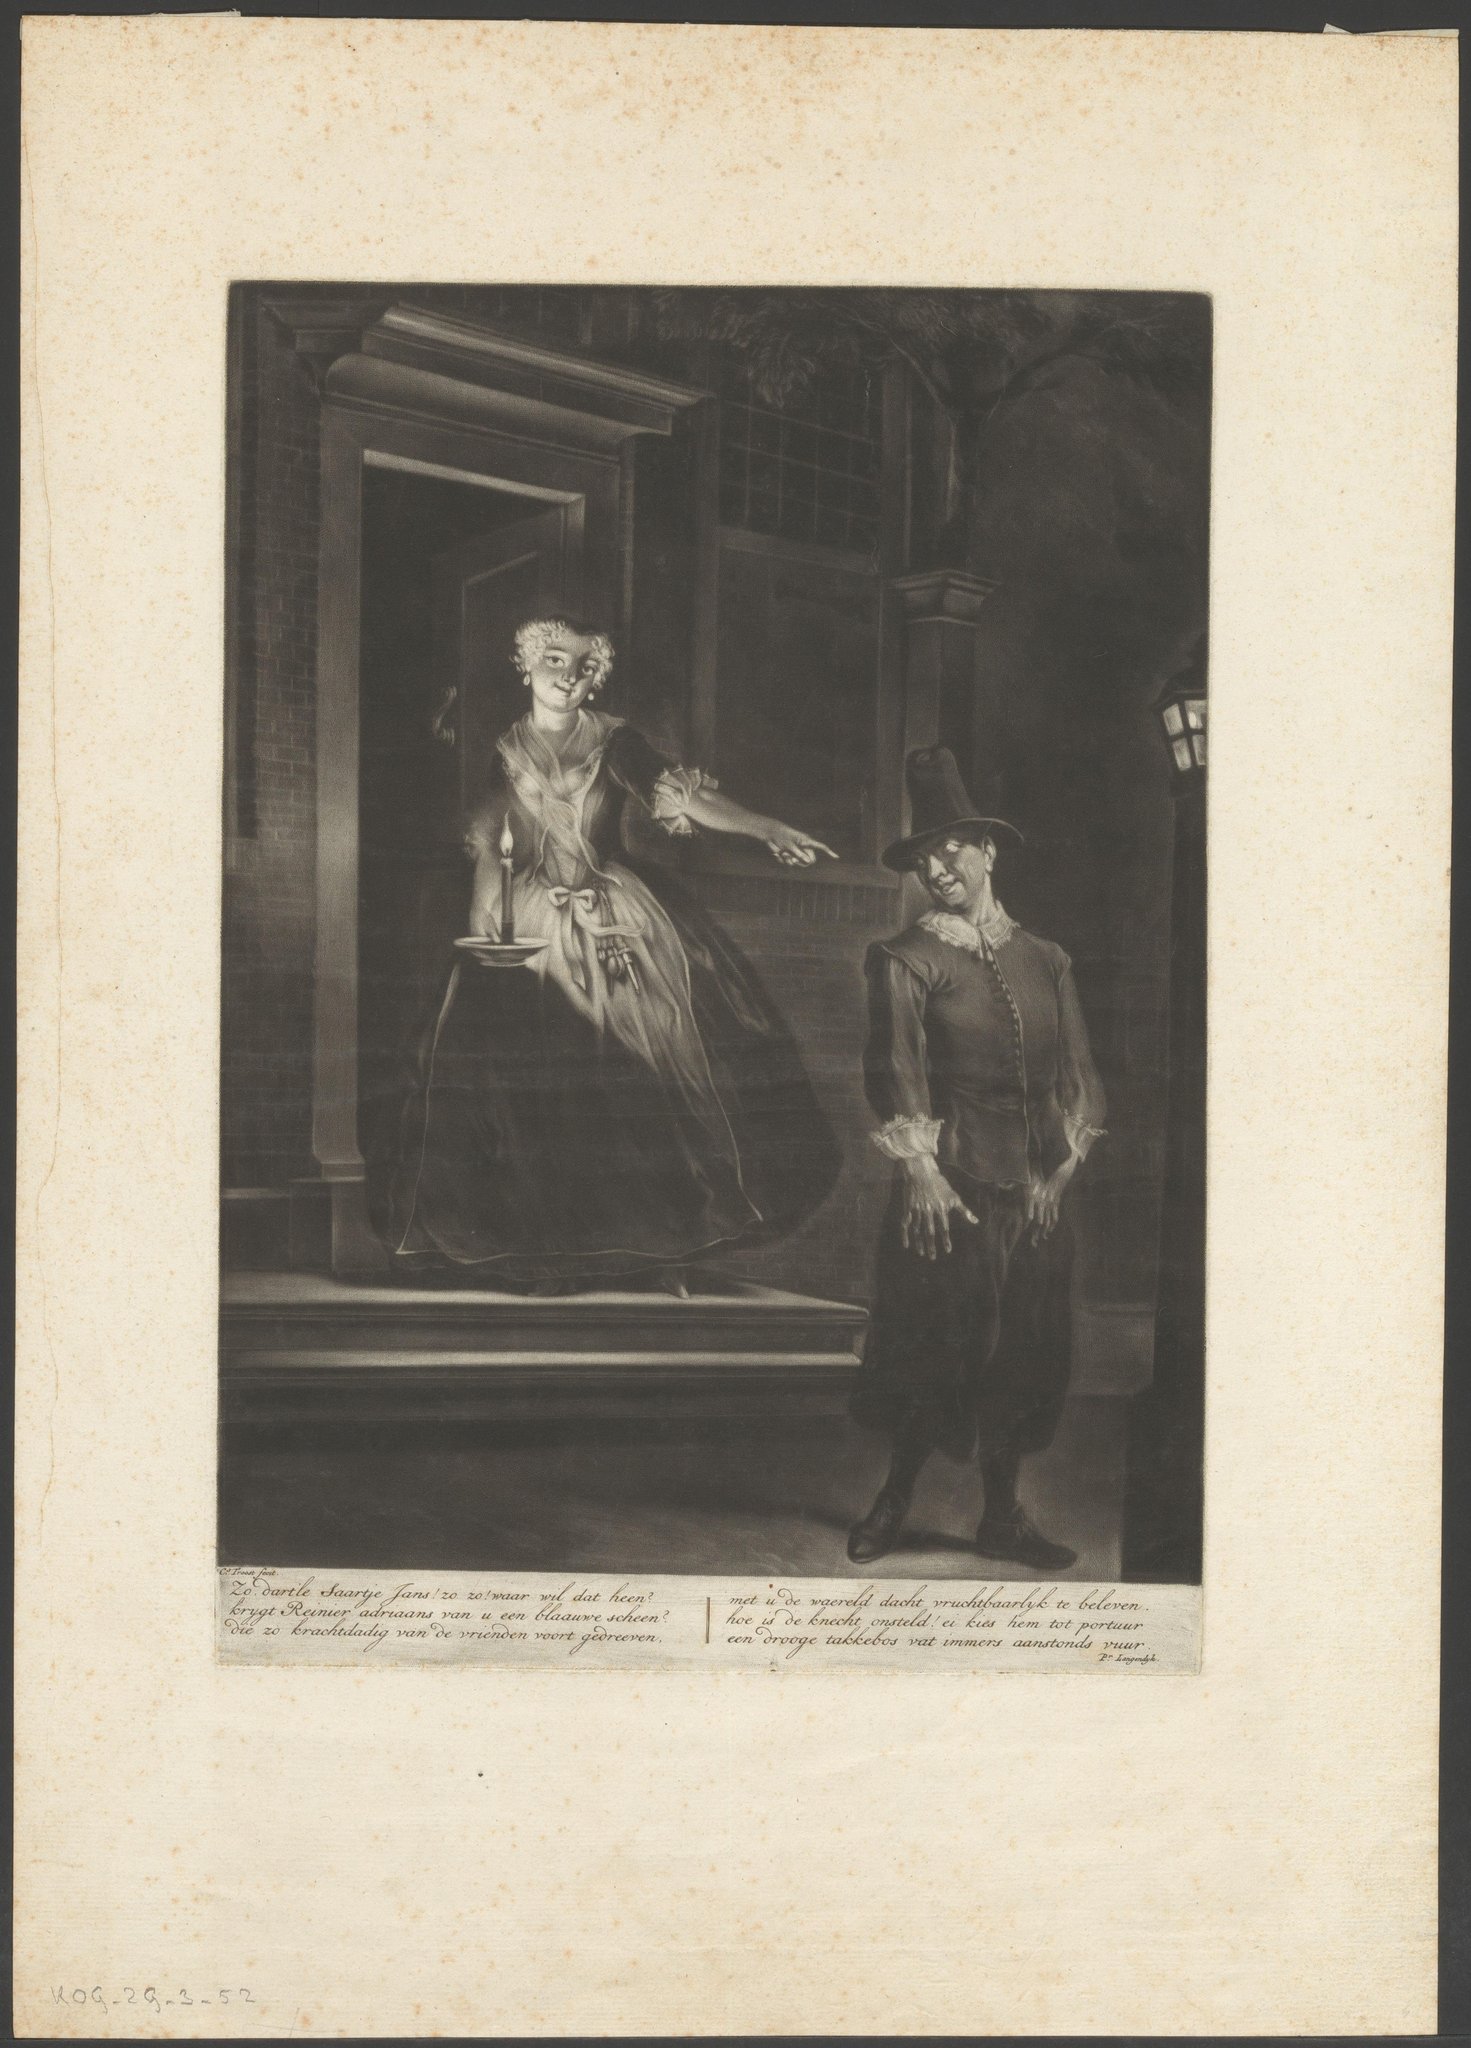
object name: print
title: Jan Claasz of de gewaande dienstmaagd: de liefdesverklaring van Reinier Adriaansz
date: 1706-1750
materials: paper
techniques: engraving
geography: amsterdam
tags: being refused, the proposal rejected, candle (+ kindling a light; lit, burning light, lamp, candle), comedy, night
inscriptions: collector's mark: Lugt 2488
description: Nachtgezicht. Reinier Adriaansz verklaart Saartje Jansz de liefde. Zij staat met een kaars in de deuropening. Met zesregelige tekst in de marge. Scène uit de komedie 'Jan Claasz of de gewaande dienstmaagd' van Thomas Asselijn.